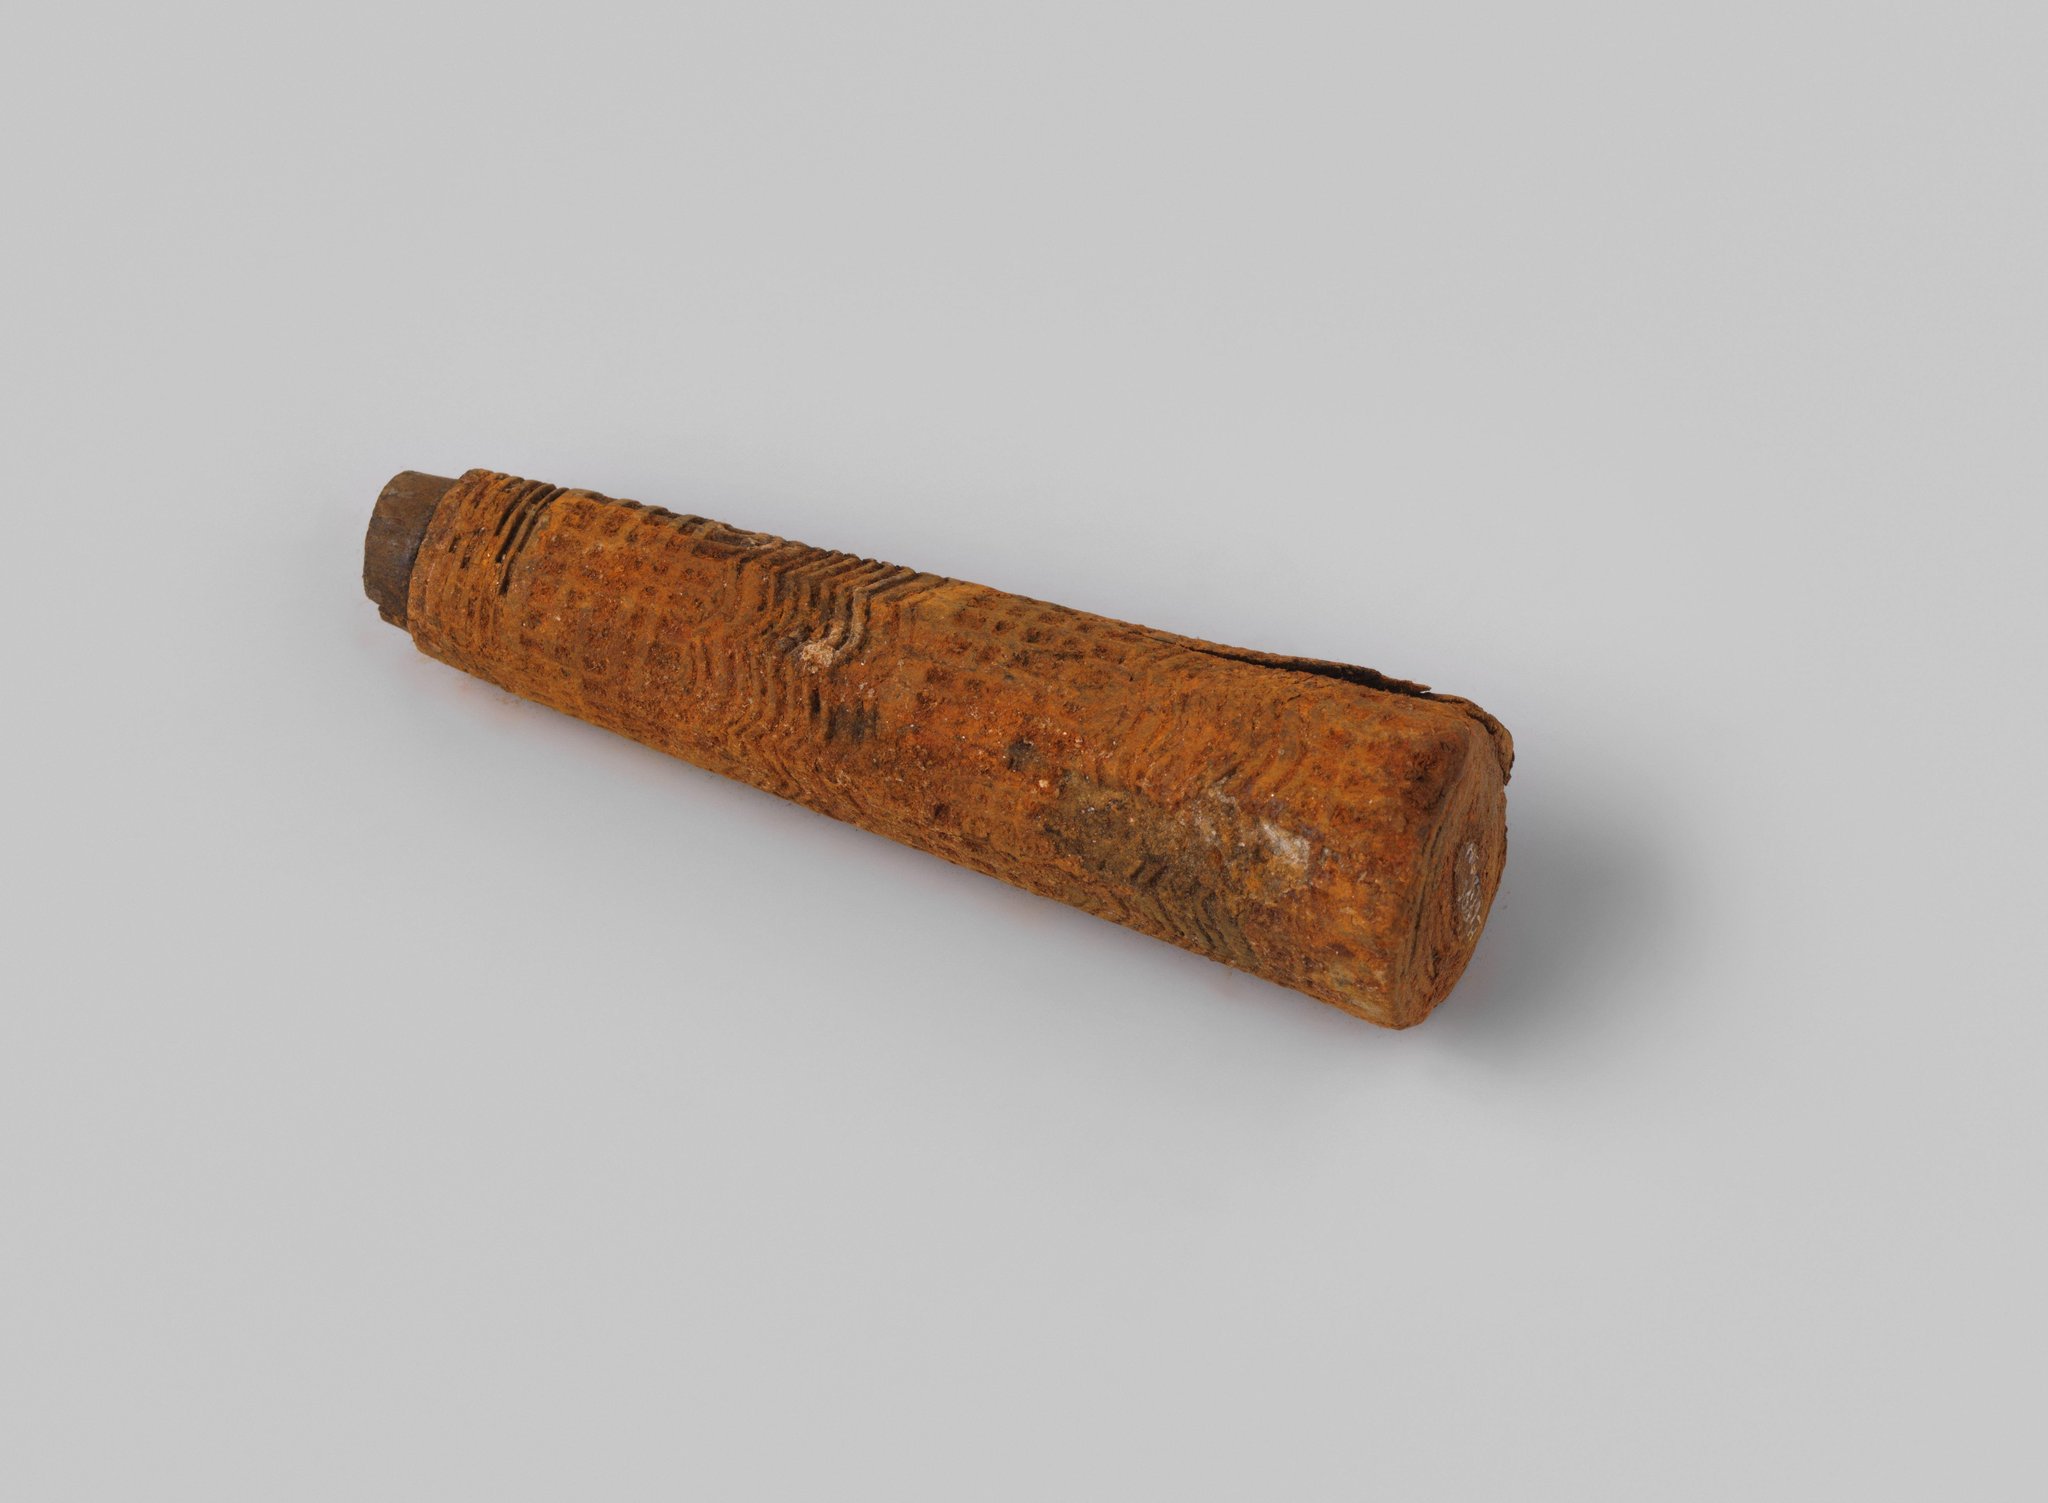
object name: knife handle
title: Messenheft uit het wrak van de Oost-Indiëvaarder Hollandia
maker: Anonymous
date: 1700-1743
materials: wood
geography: netherlands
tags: verenigde oostindische compagnie, hollandia (schip), annet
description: Knife, handle, cylindrical: tapering; id. NG 1979-403H, ferrules id. NG 1980-27H426.